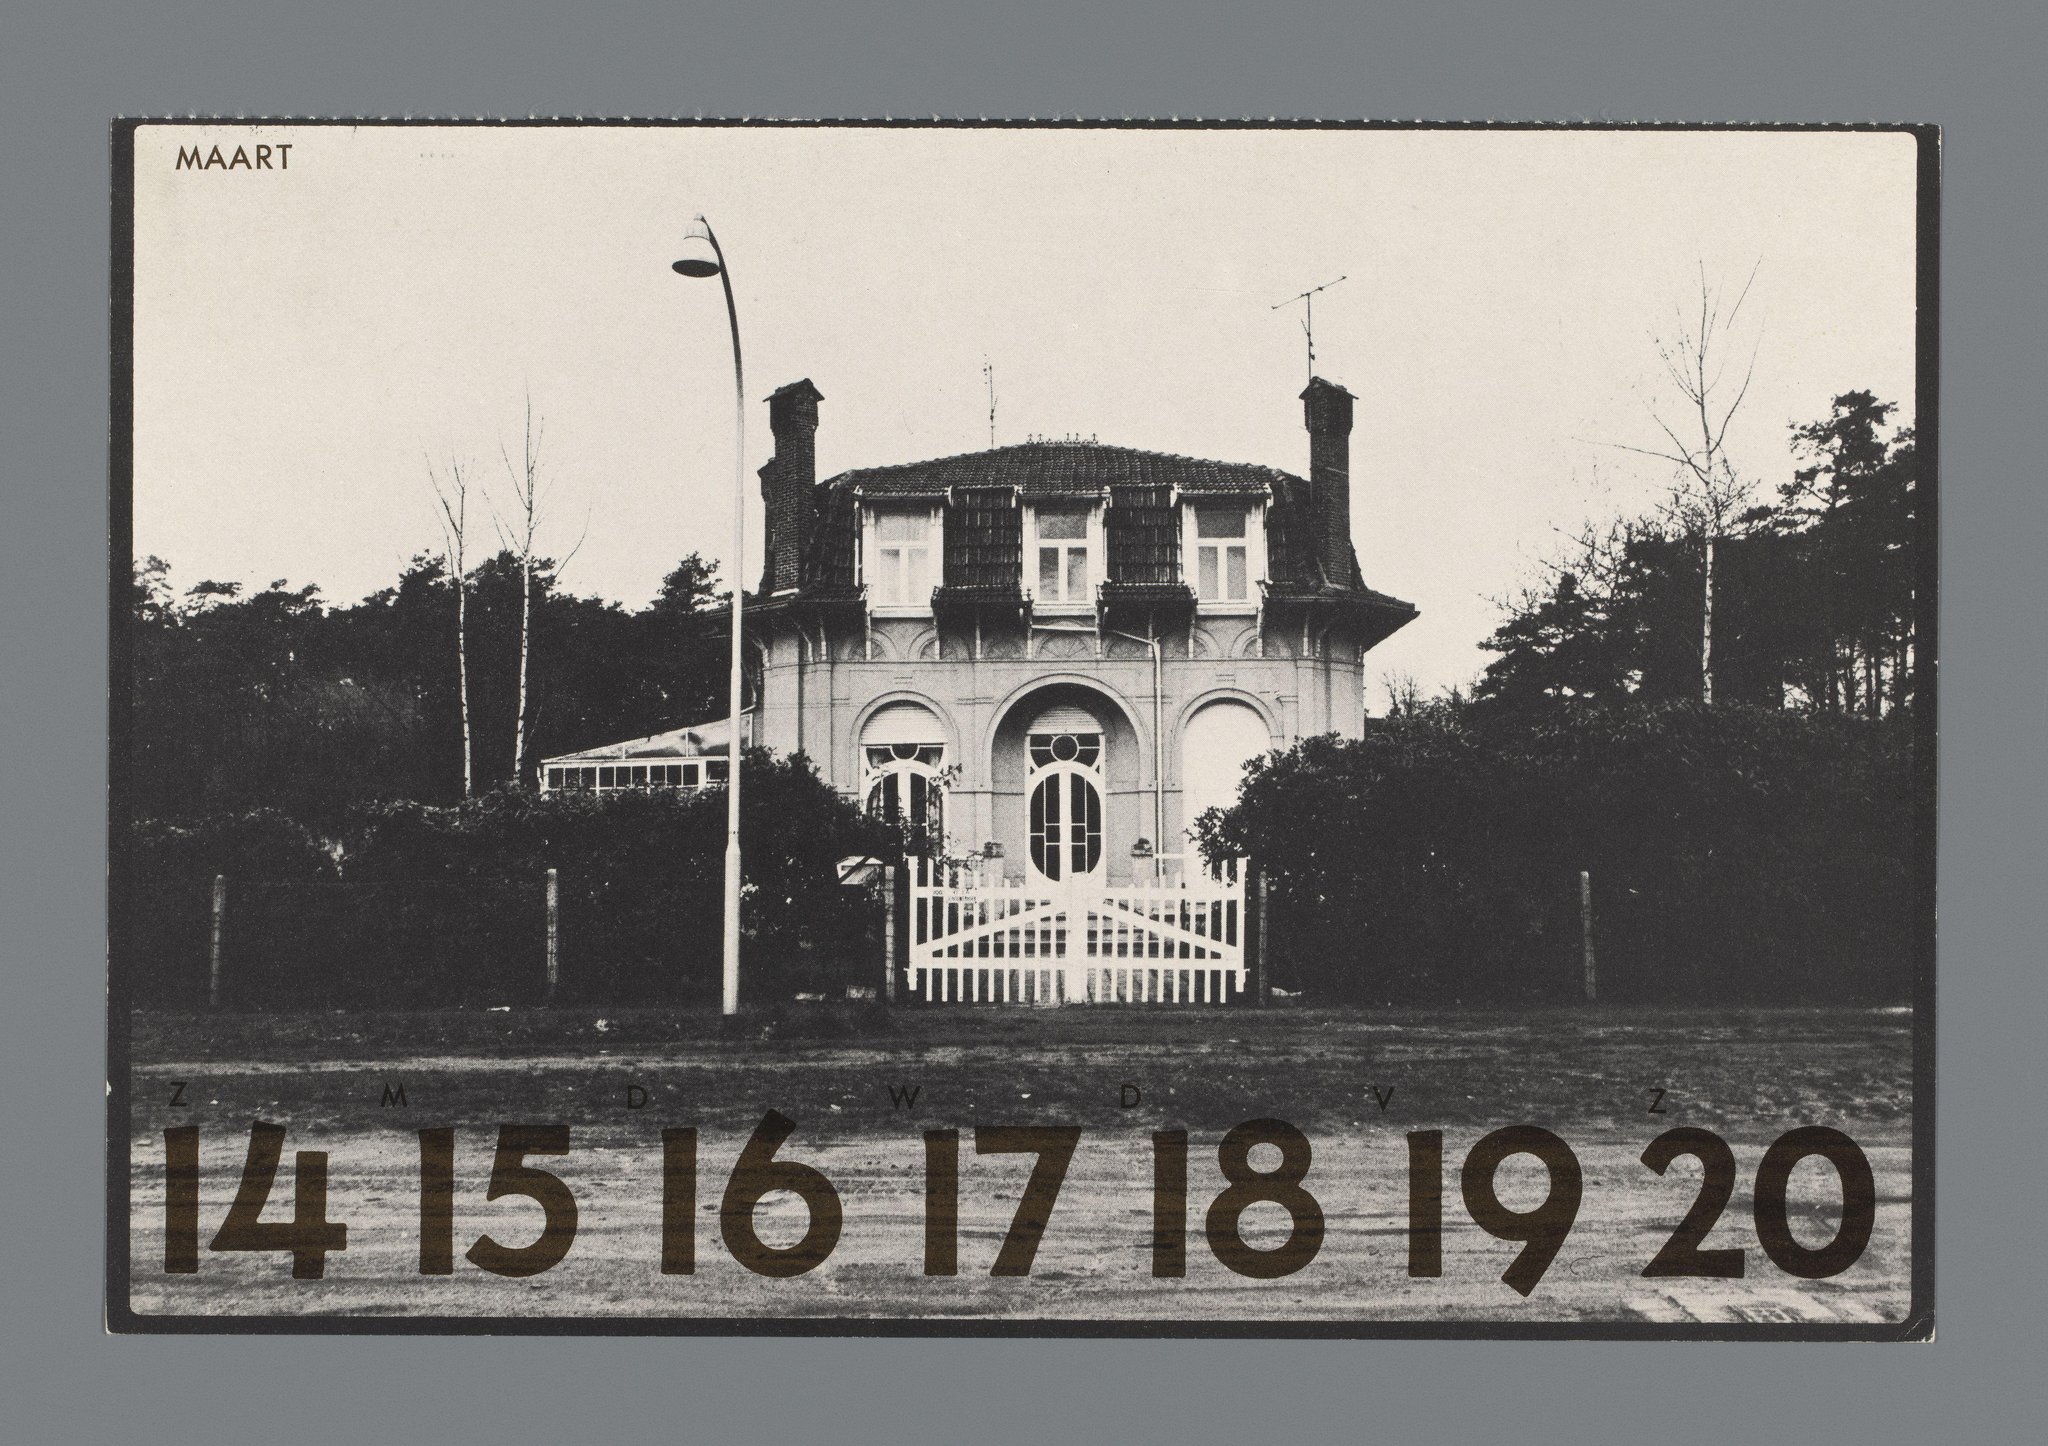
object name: photograph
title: België. Huizen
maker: Anonymous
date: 1900-1950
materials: paper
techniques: offset printed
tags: belgium